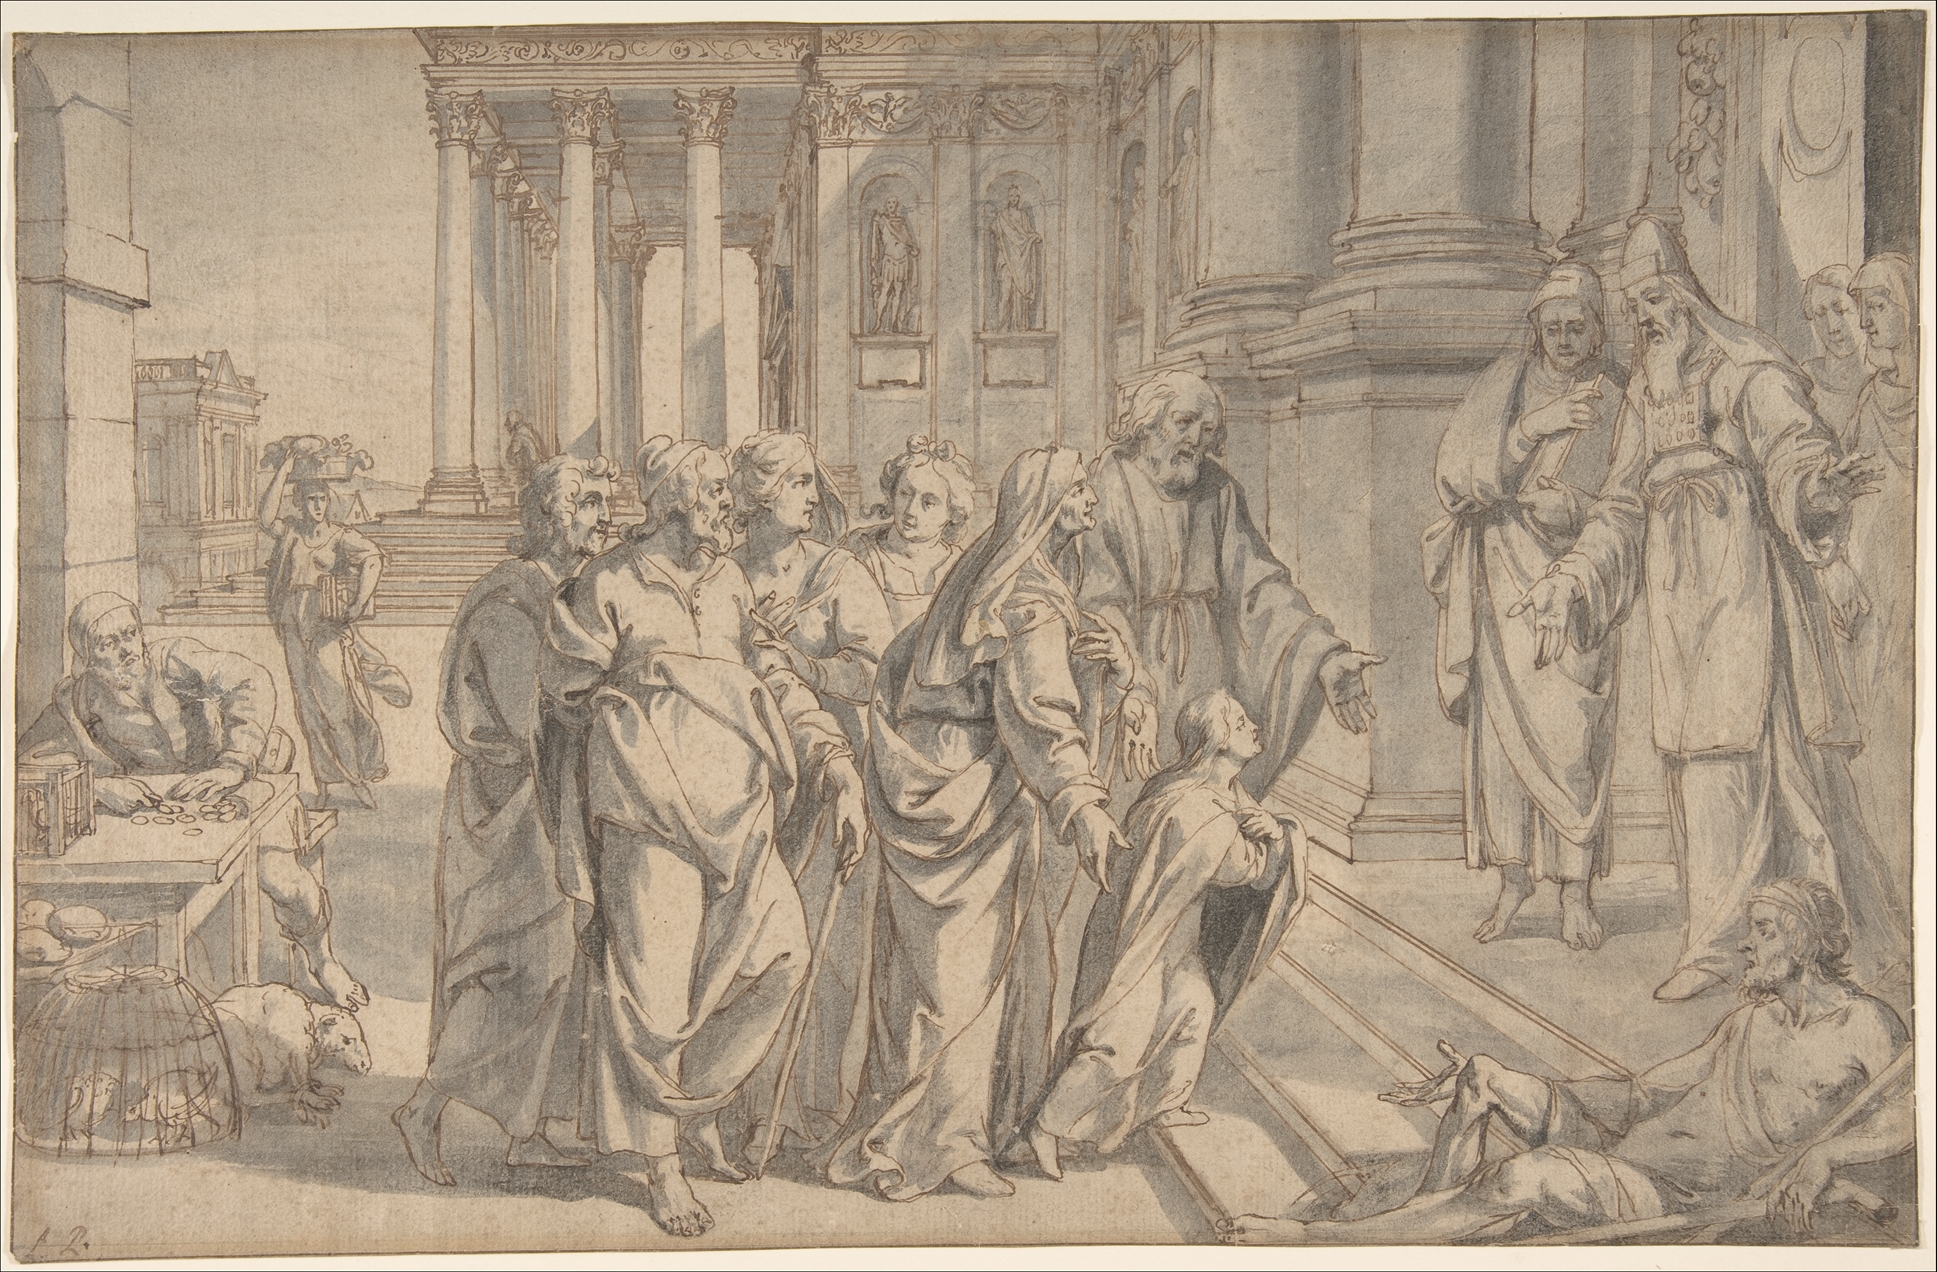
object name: drawing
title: The Presentation of the Virgin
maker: philippe de champaigne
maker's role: artist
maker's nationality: french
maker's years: 1602-1674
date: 1601-1700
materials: chalk, ink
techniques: brush, pen, wash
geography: france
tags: men,women,virgin mary